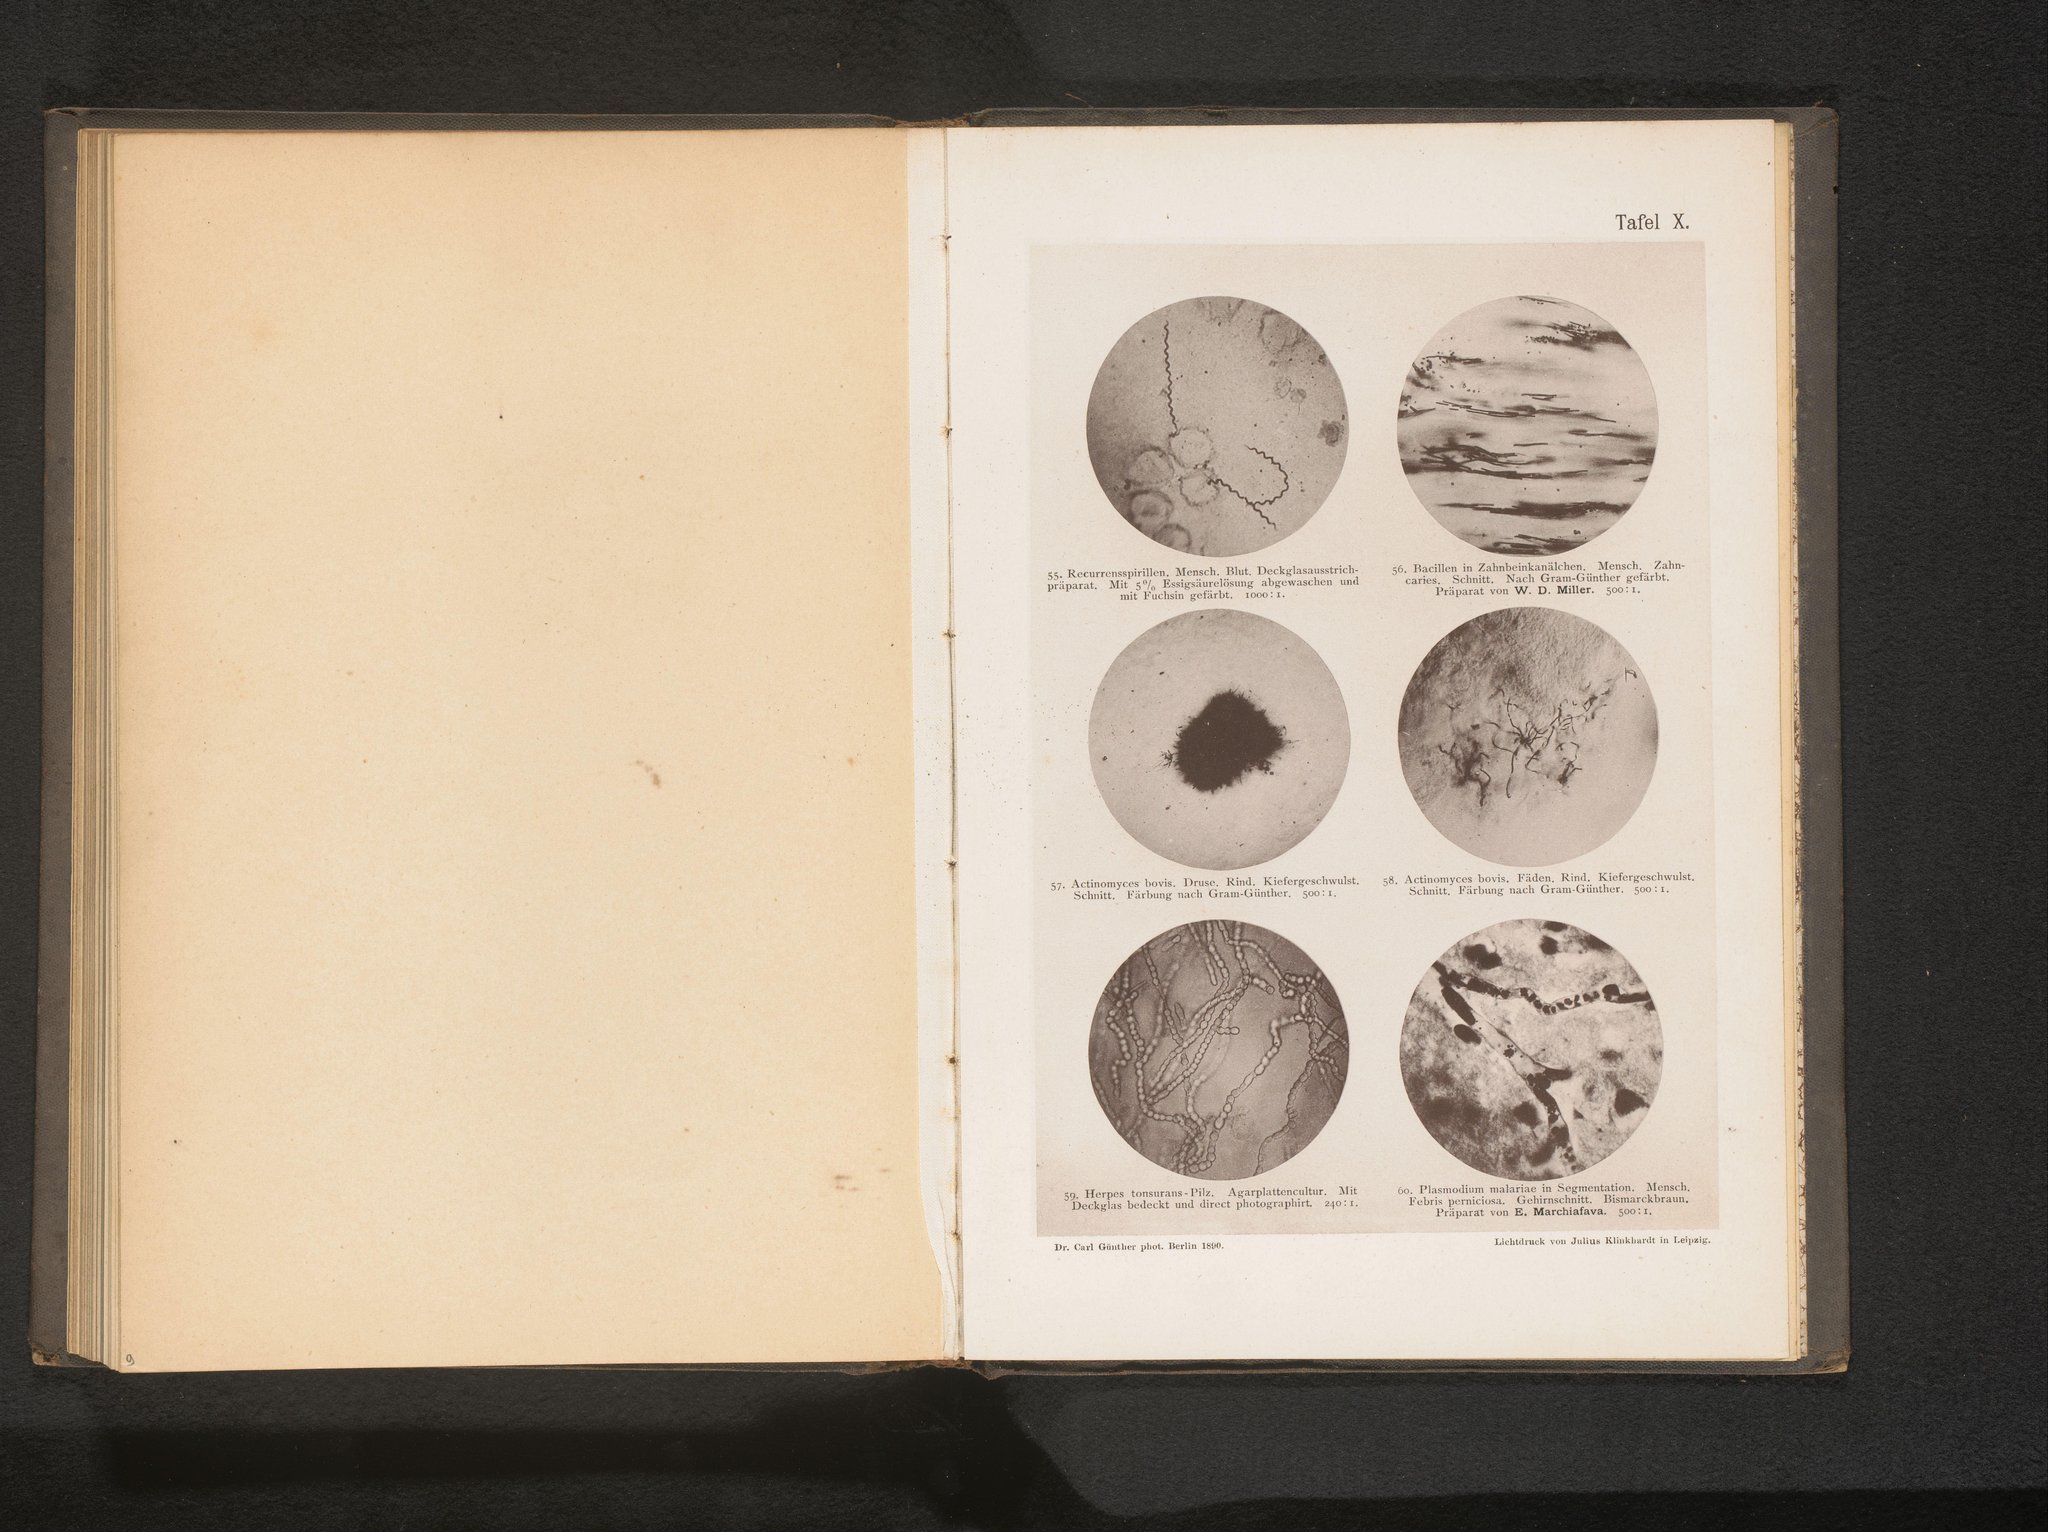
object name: page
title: Zes microscoopopnamen van bacteriën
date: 1880-1890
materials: paper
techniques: photograph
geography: leipzig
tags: unicellular animals, bacteria, bacilli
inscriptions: inscription: ‘55. Recurrensspirillen. Mensch. Blut. Deckgalsausstrichpräparat. Mit 5% Essigsäurelösung abgewaschen und mit Fuchsin gefärbt. 1000:1. 56. Bacillen in Zahnbeinkanälchen. Mensch. Zahncaries. Schnitt. Nach Gram-Günther gefärbt. Präparat von W.D. Miller. 500:1. 57. Actinomyces bovis. Druse. Rind. Kiefergeschwulst. Schnitt. Färbung nach Gram- Günther. 500:1. 58. Actinomyces bovis. Fäden. Rind. Kiefergeschwulst. Schnitt. Färbung nach Gram-Günther. 500:1. 59. Herpes tonsurans-Pilz. Agarplattencultur. Mit Deckglas bedeckt und direct photographirt. 240:1. 60. Plasmodium malariae in Segmentation. Mensch. Febris perniciosa. Gehirnschnitt. Bismarckbraun. Präparat von E. Marchiafava. 500:1.’, number: ‘Tafel X.’